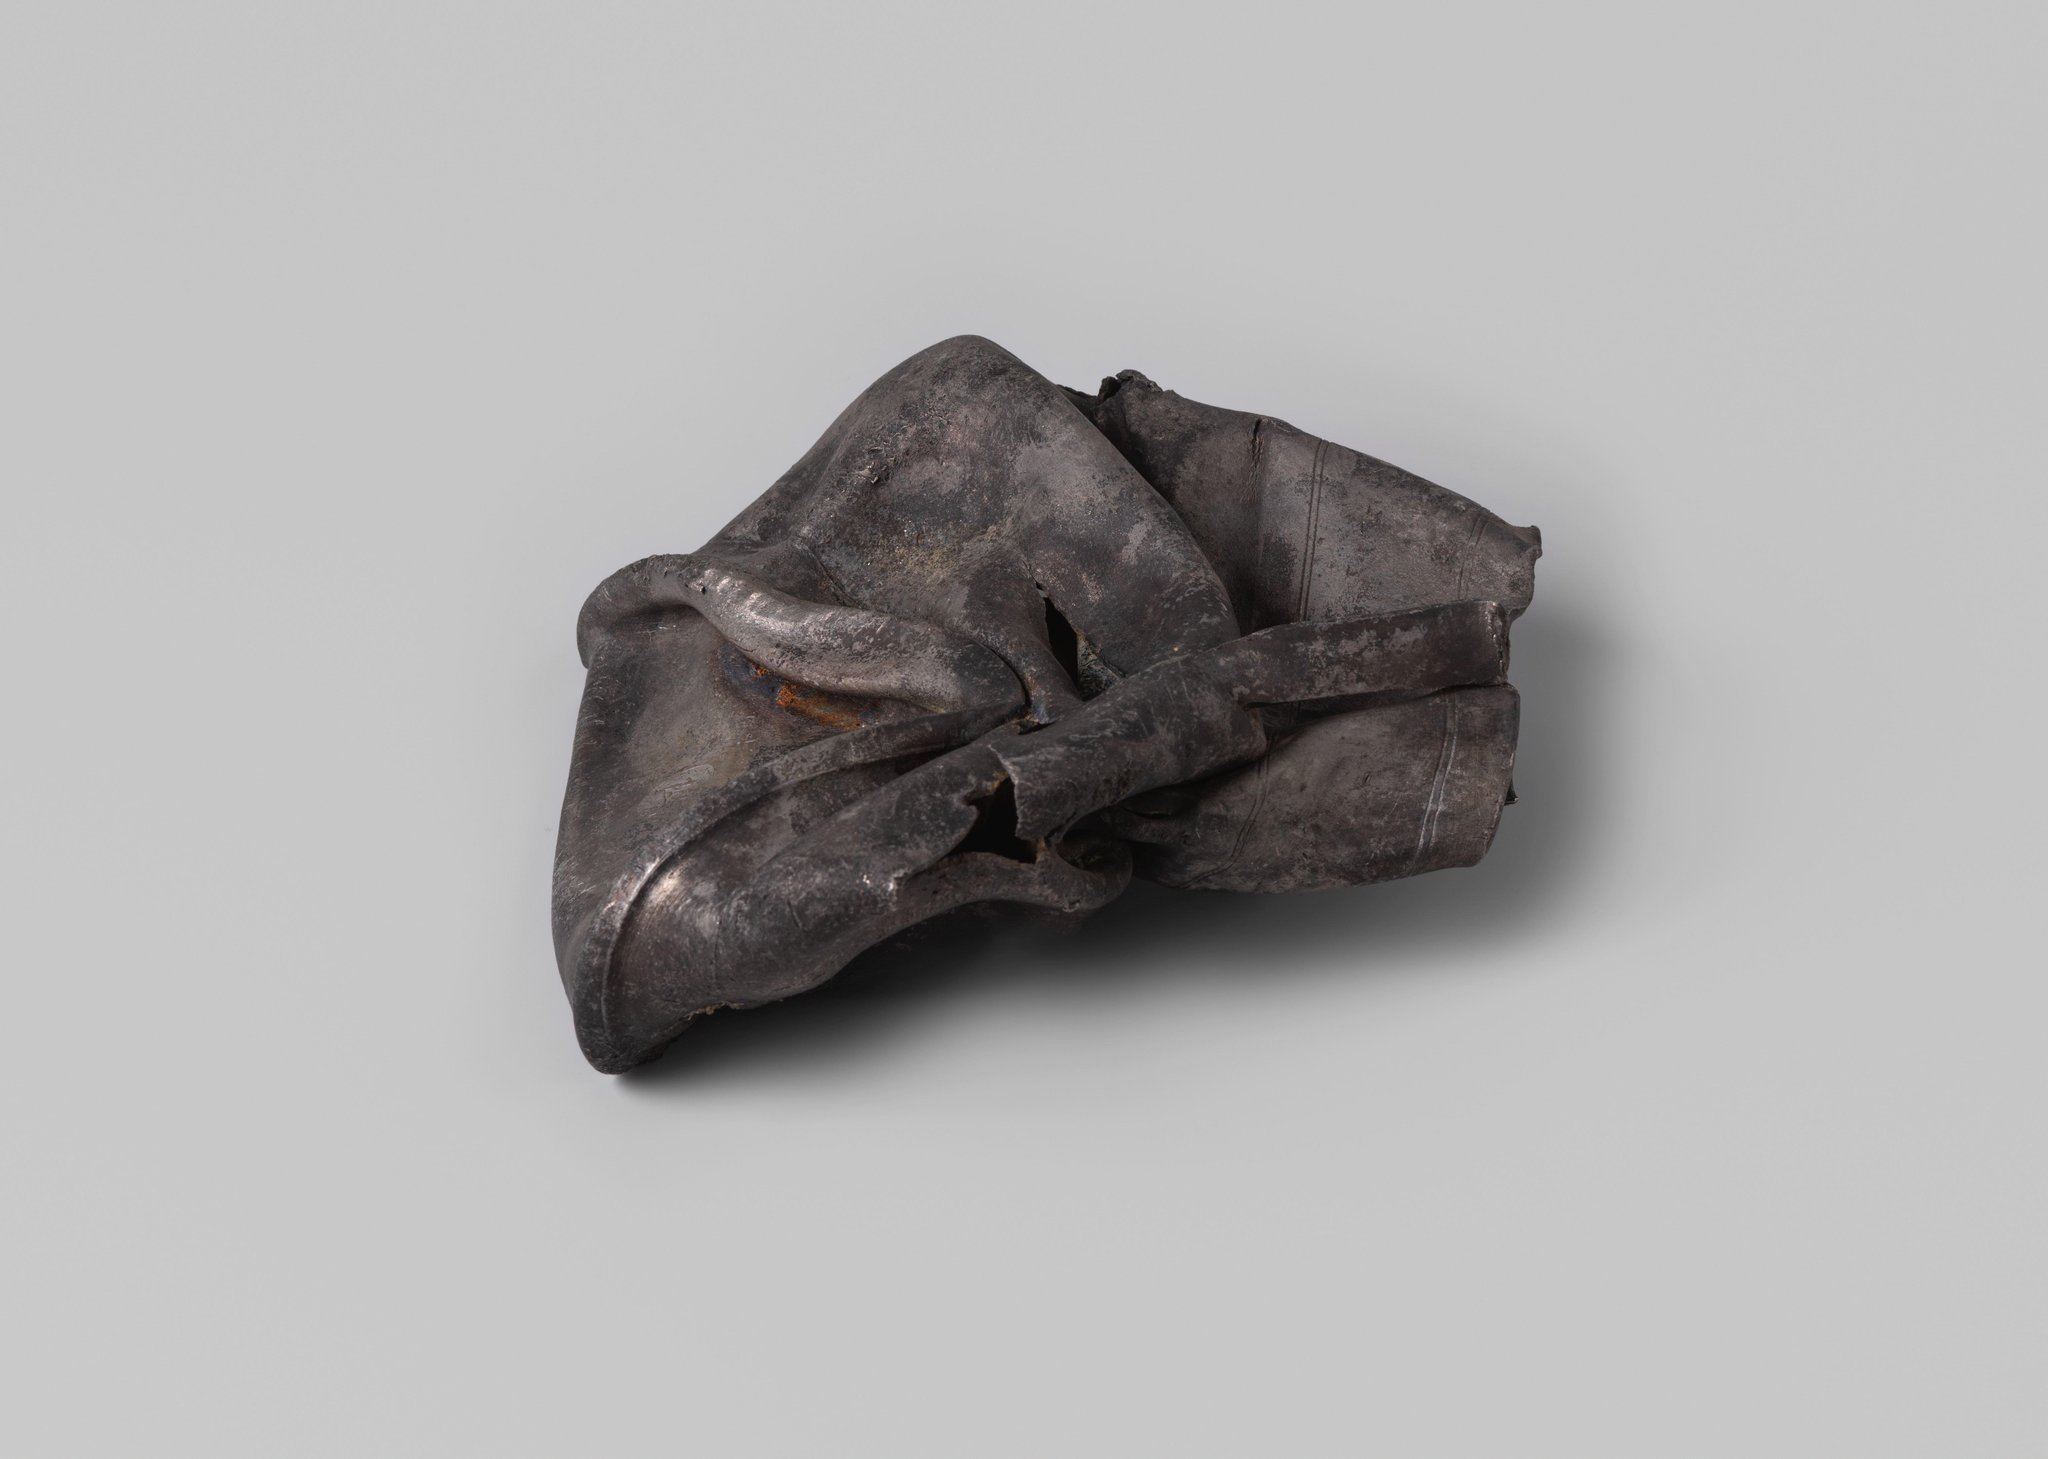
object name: ewer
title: Kan uit het wrak van de Oost-Indiëvaarder Hollandia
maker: Anonymous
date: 1700-1743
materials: tin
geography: netherlands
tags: verenigde oostindische compagnie, hollandia (schip), annet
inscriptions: mark: ‘AVOC’